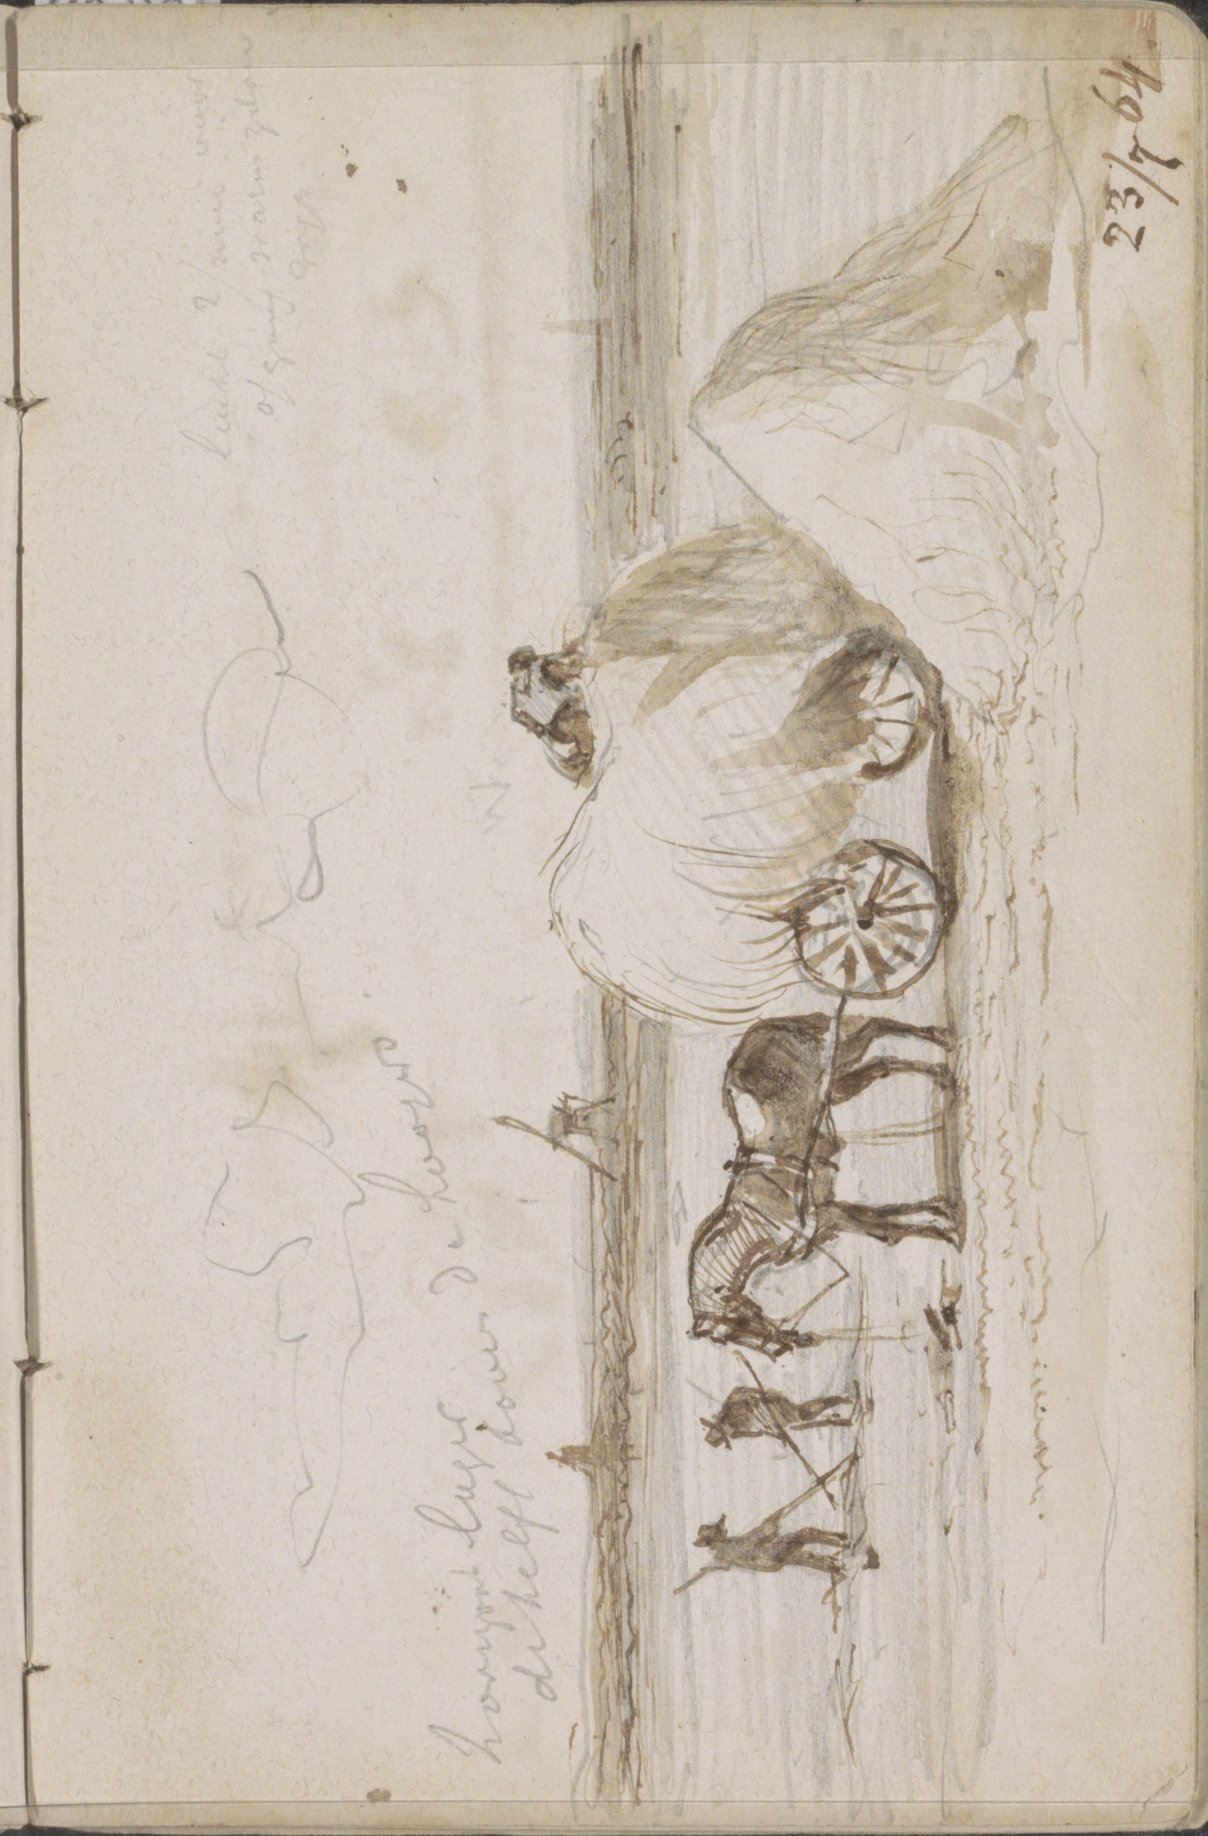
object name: sketchbook leaf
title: Landschap met een trekpaard met een hooiwagen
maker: johannes tavenraat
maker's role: draughtsman, painter, print maker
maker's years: 1809-1881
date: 1807-1864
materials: ink, paper, pencil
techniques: brush, pen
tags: windmill in landscape, horse, agriculture, hay-wagon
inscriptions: date and inscription: ‘23/7 64’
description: Het paard staat bij een hooiberg. Op de achtergrond zijn twee arbeiders aan het werk op het land. Blad 46 recto uit een schetsboek met 65 bladen.